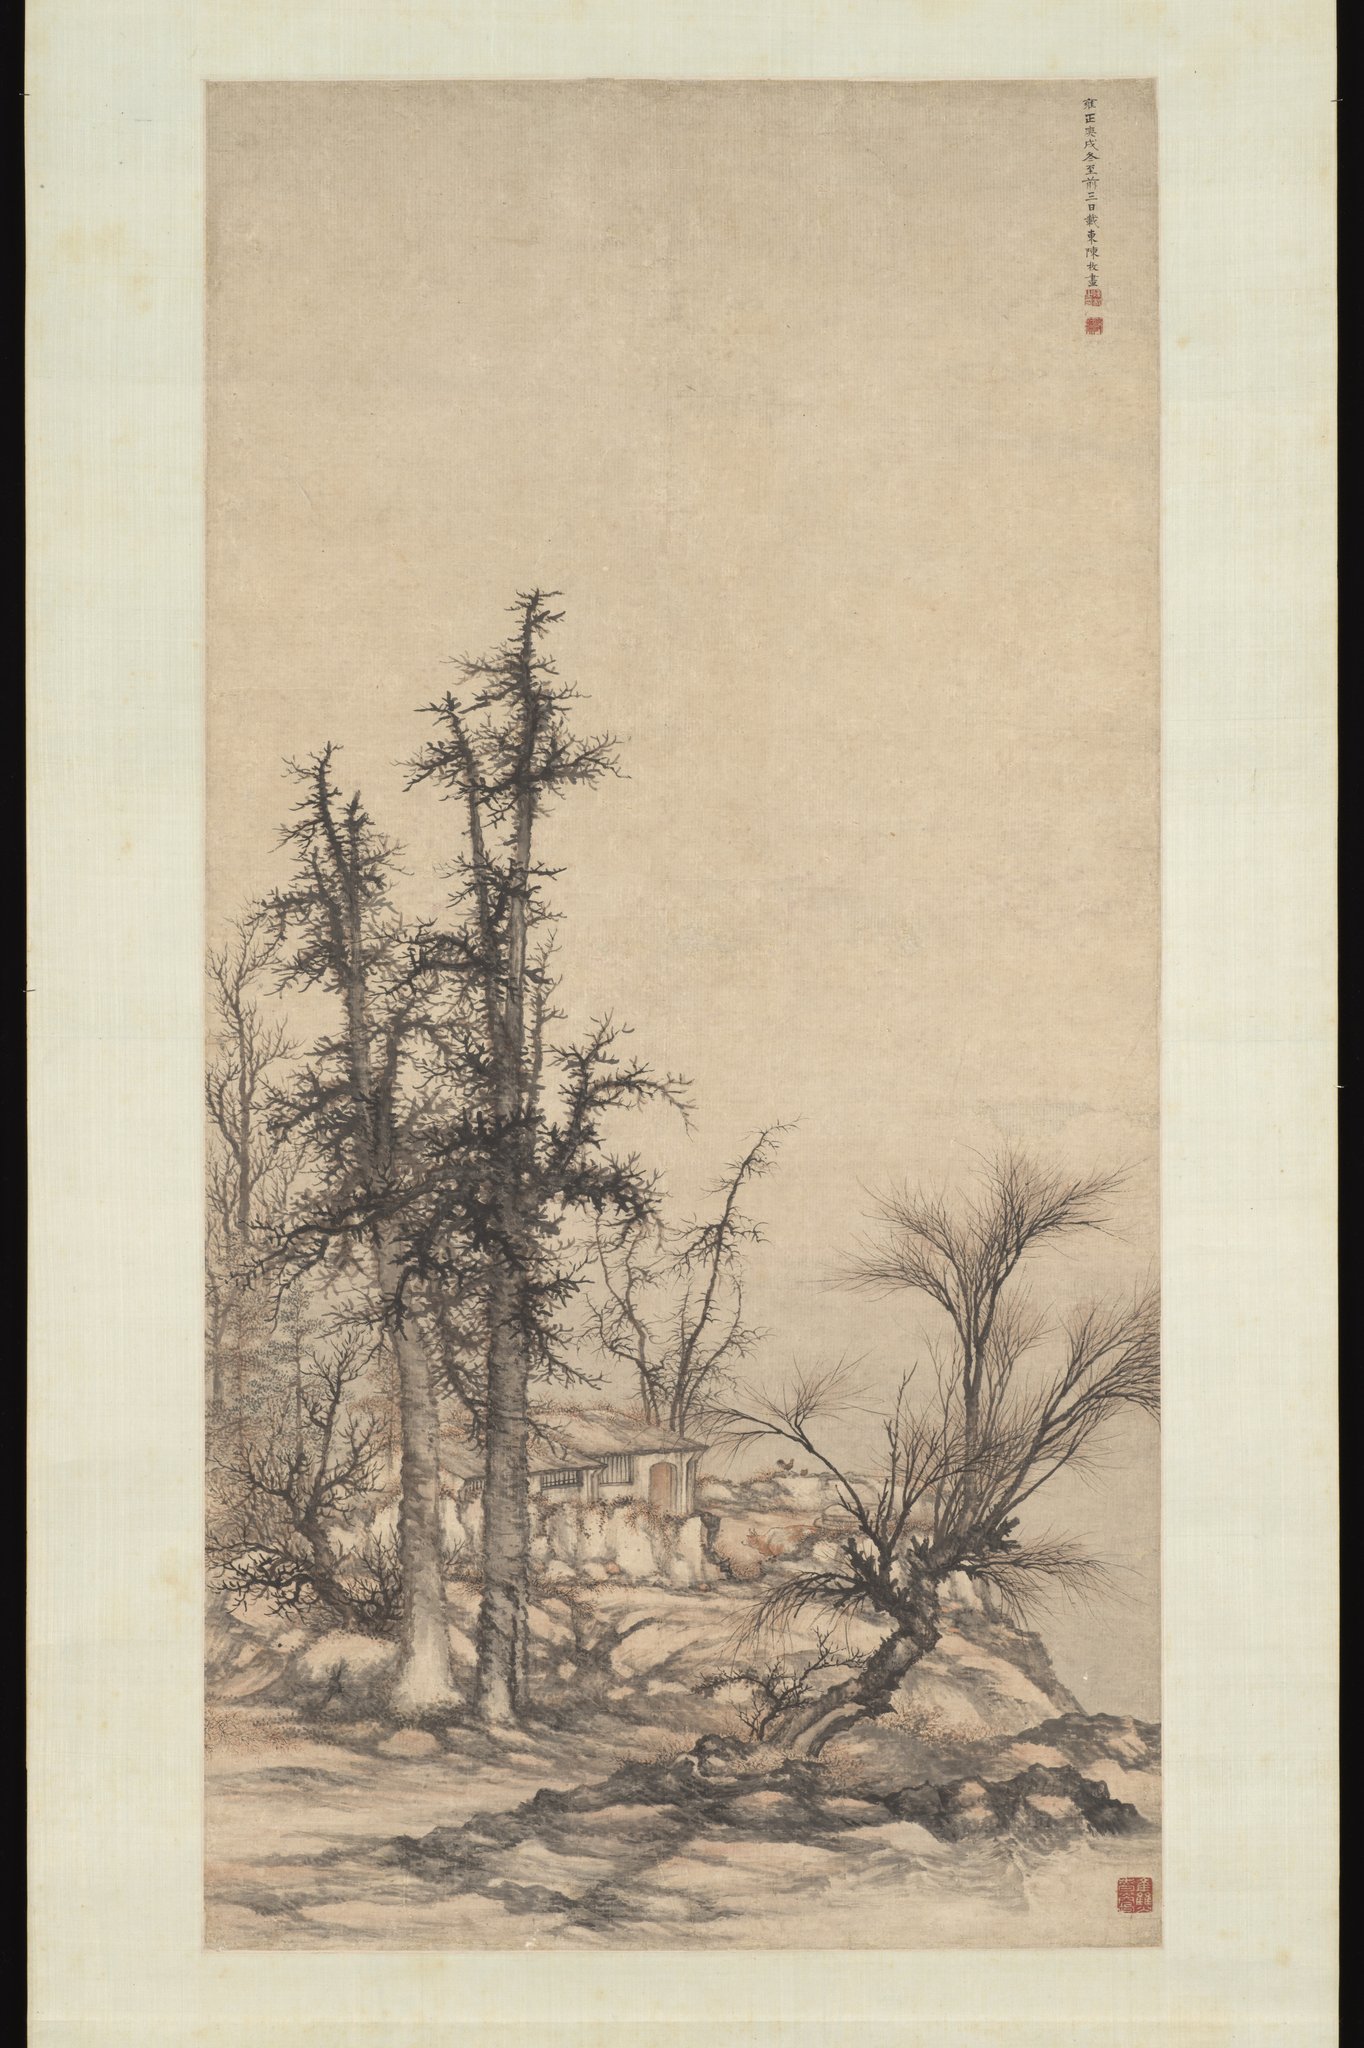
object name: hanging scroll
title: Small dwelling in a dense grove of trees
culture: chinese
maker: chen mei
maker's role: artist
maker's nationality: chinese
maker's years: 1694-1745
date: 1730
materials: ink, paper